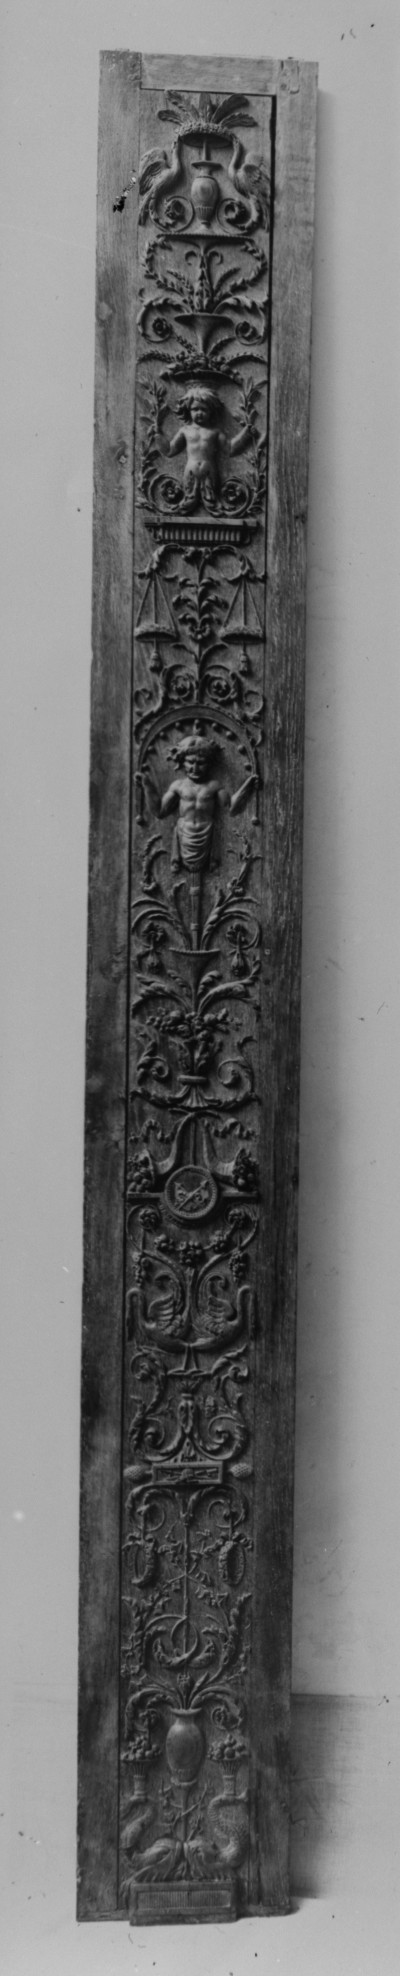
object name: pilaster panel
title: Pilaster panel (part of a set of eight)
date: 1701-1800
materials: wood